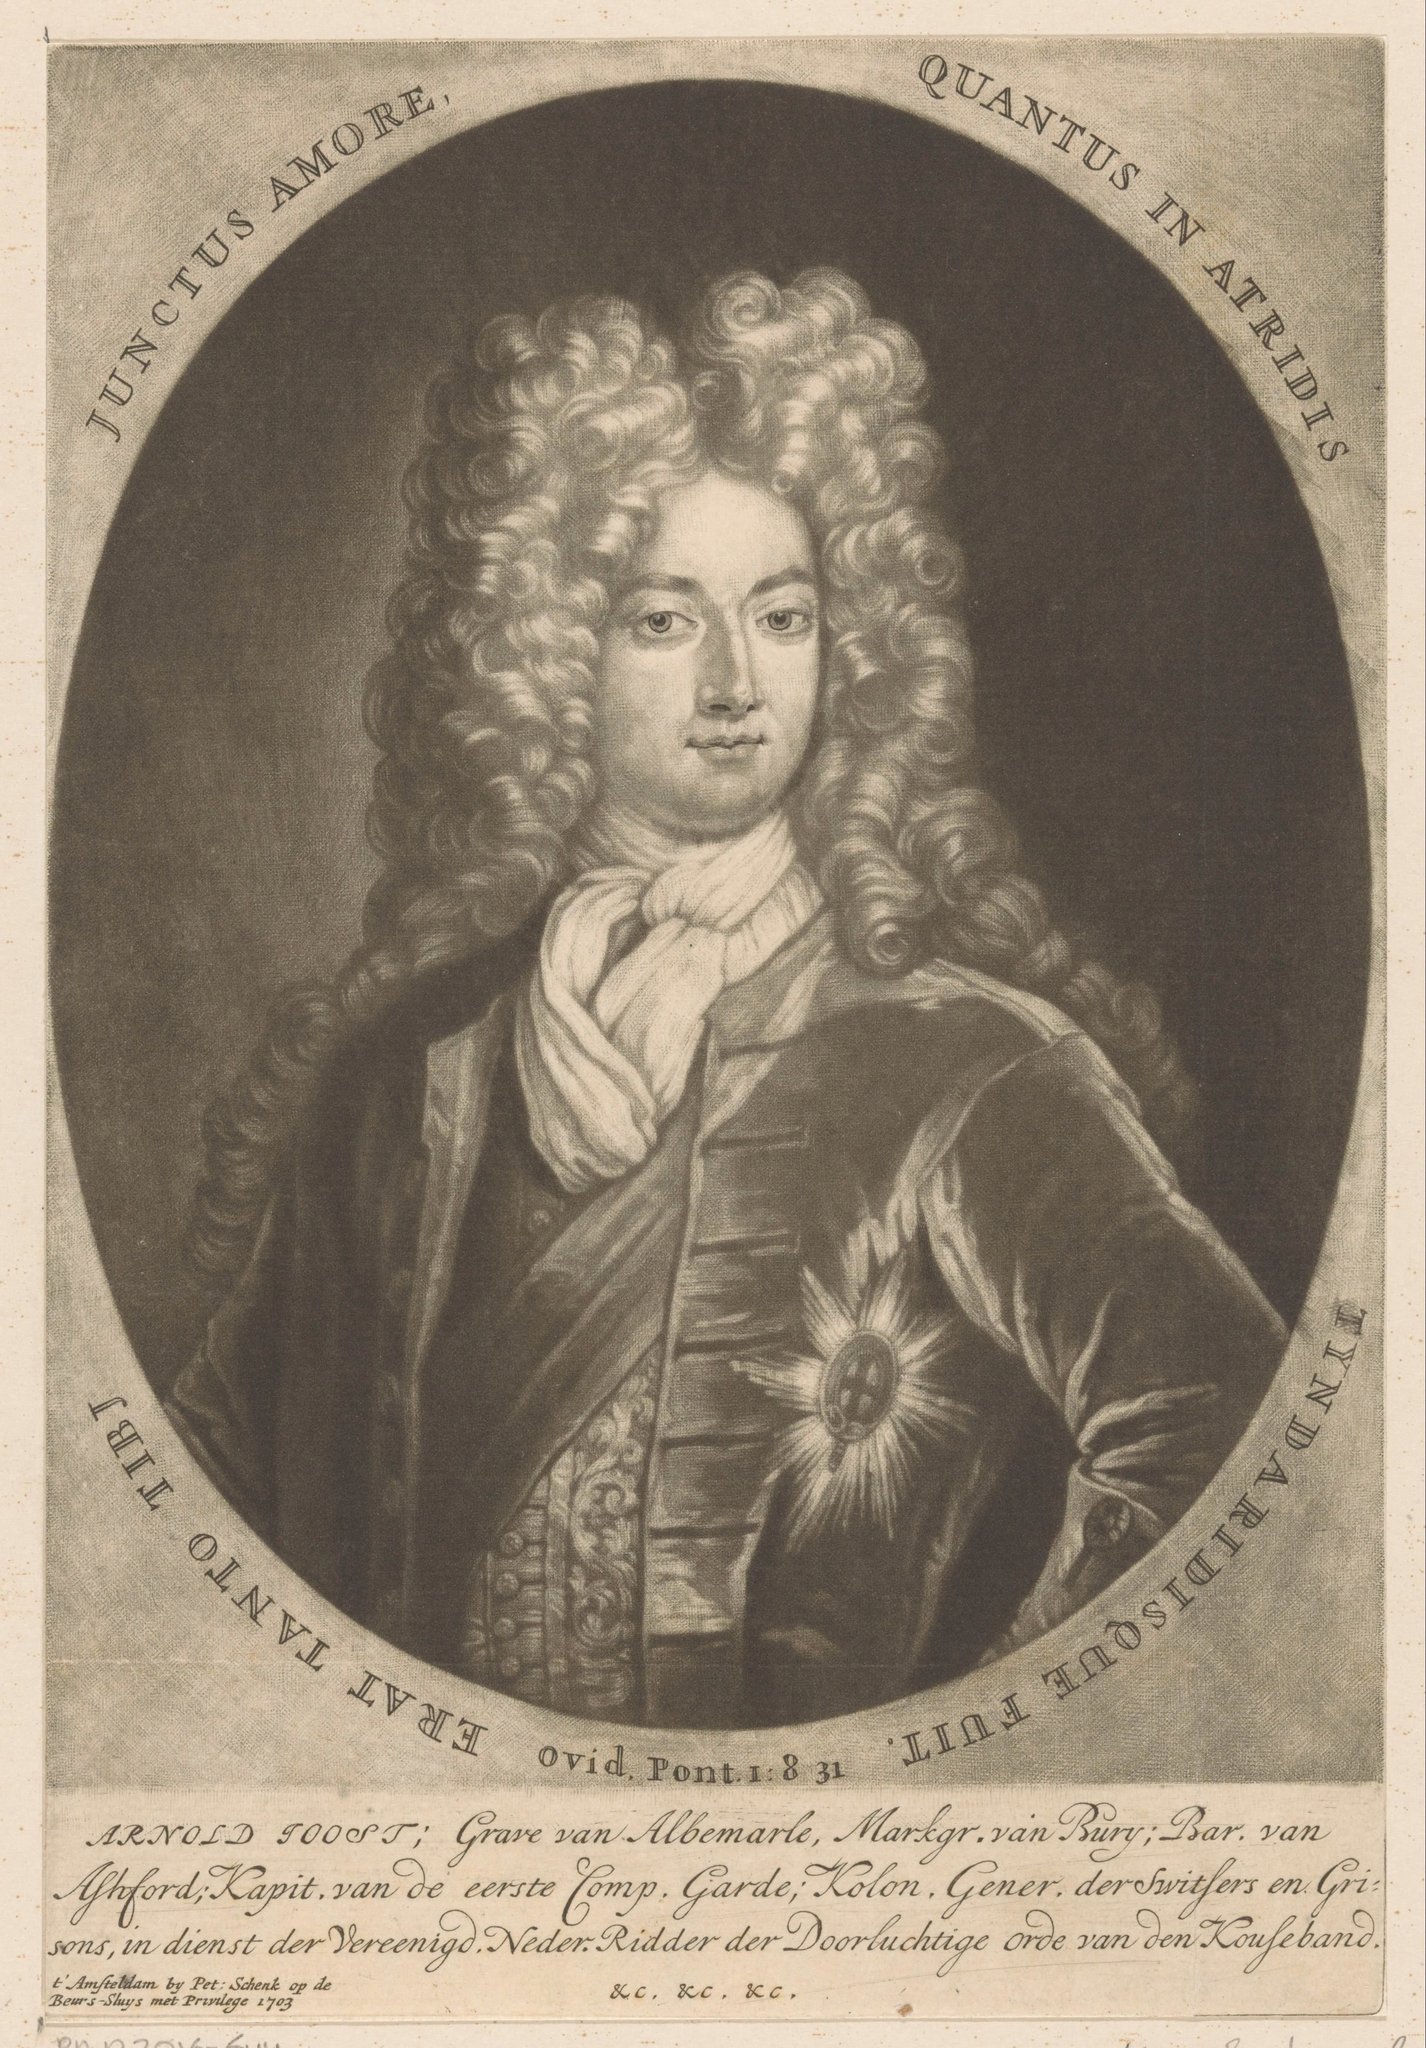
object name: print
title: Portret van Arnold Joost van Keppel, graaf van Albemarle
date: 1703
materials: paper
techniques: engraving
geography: amsterdam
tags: the hague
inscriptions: date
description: Portret van Arnold Joost van Keppel in een ovale omlijsting met randschrift. In de ondermarge zijn naam en titels.